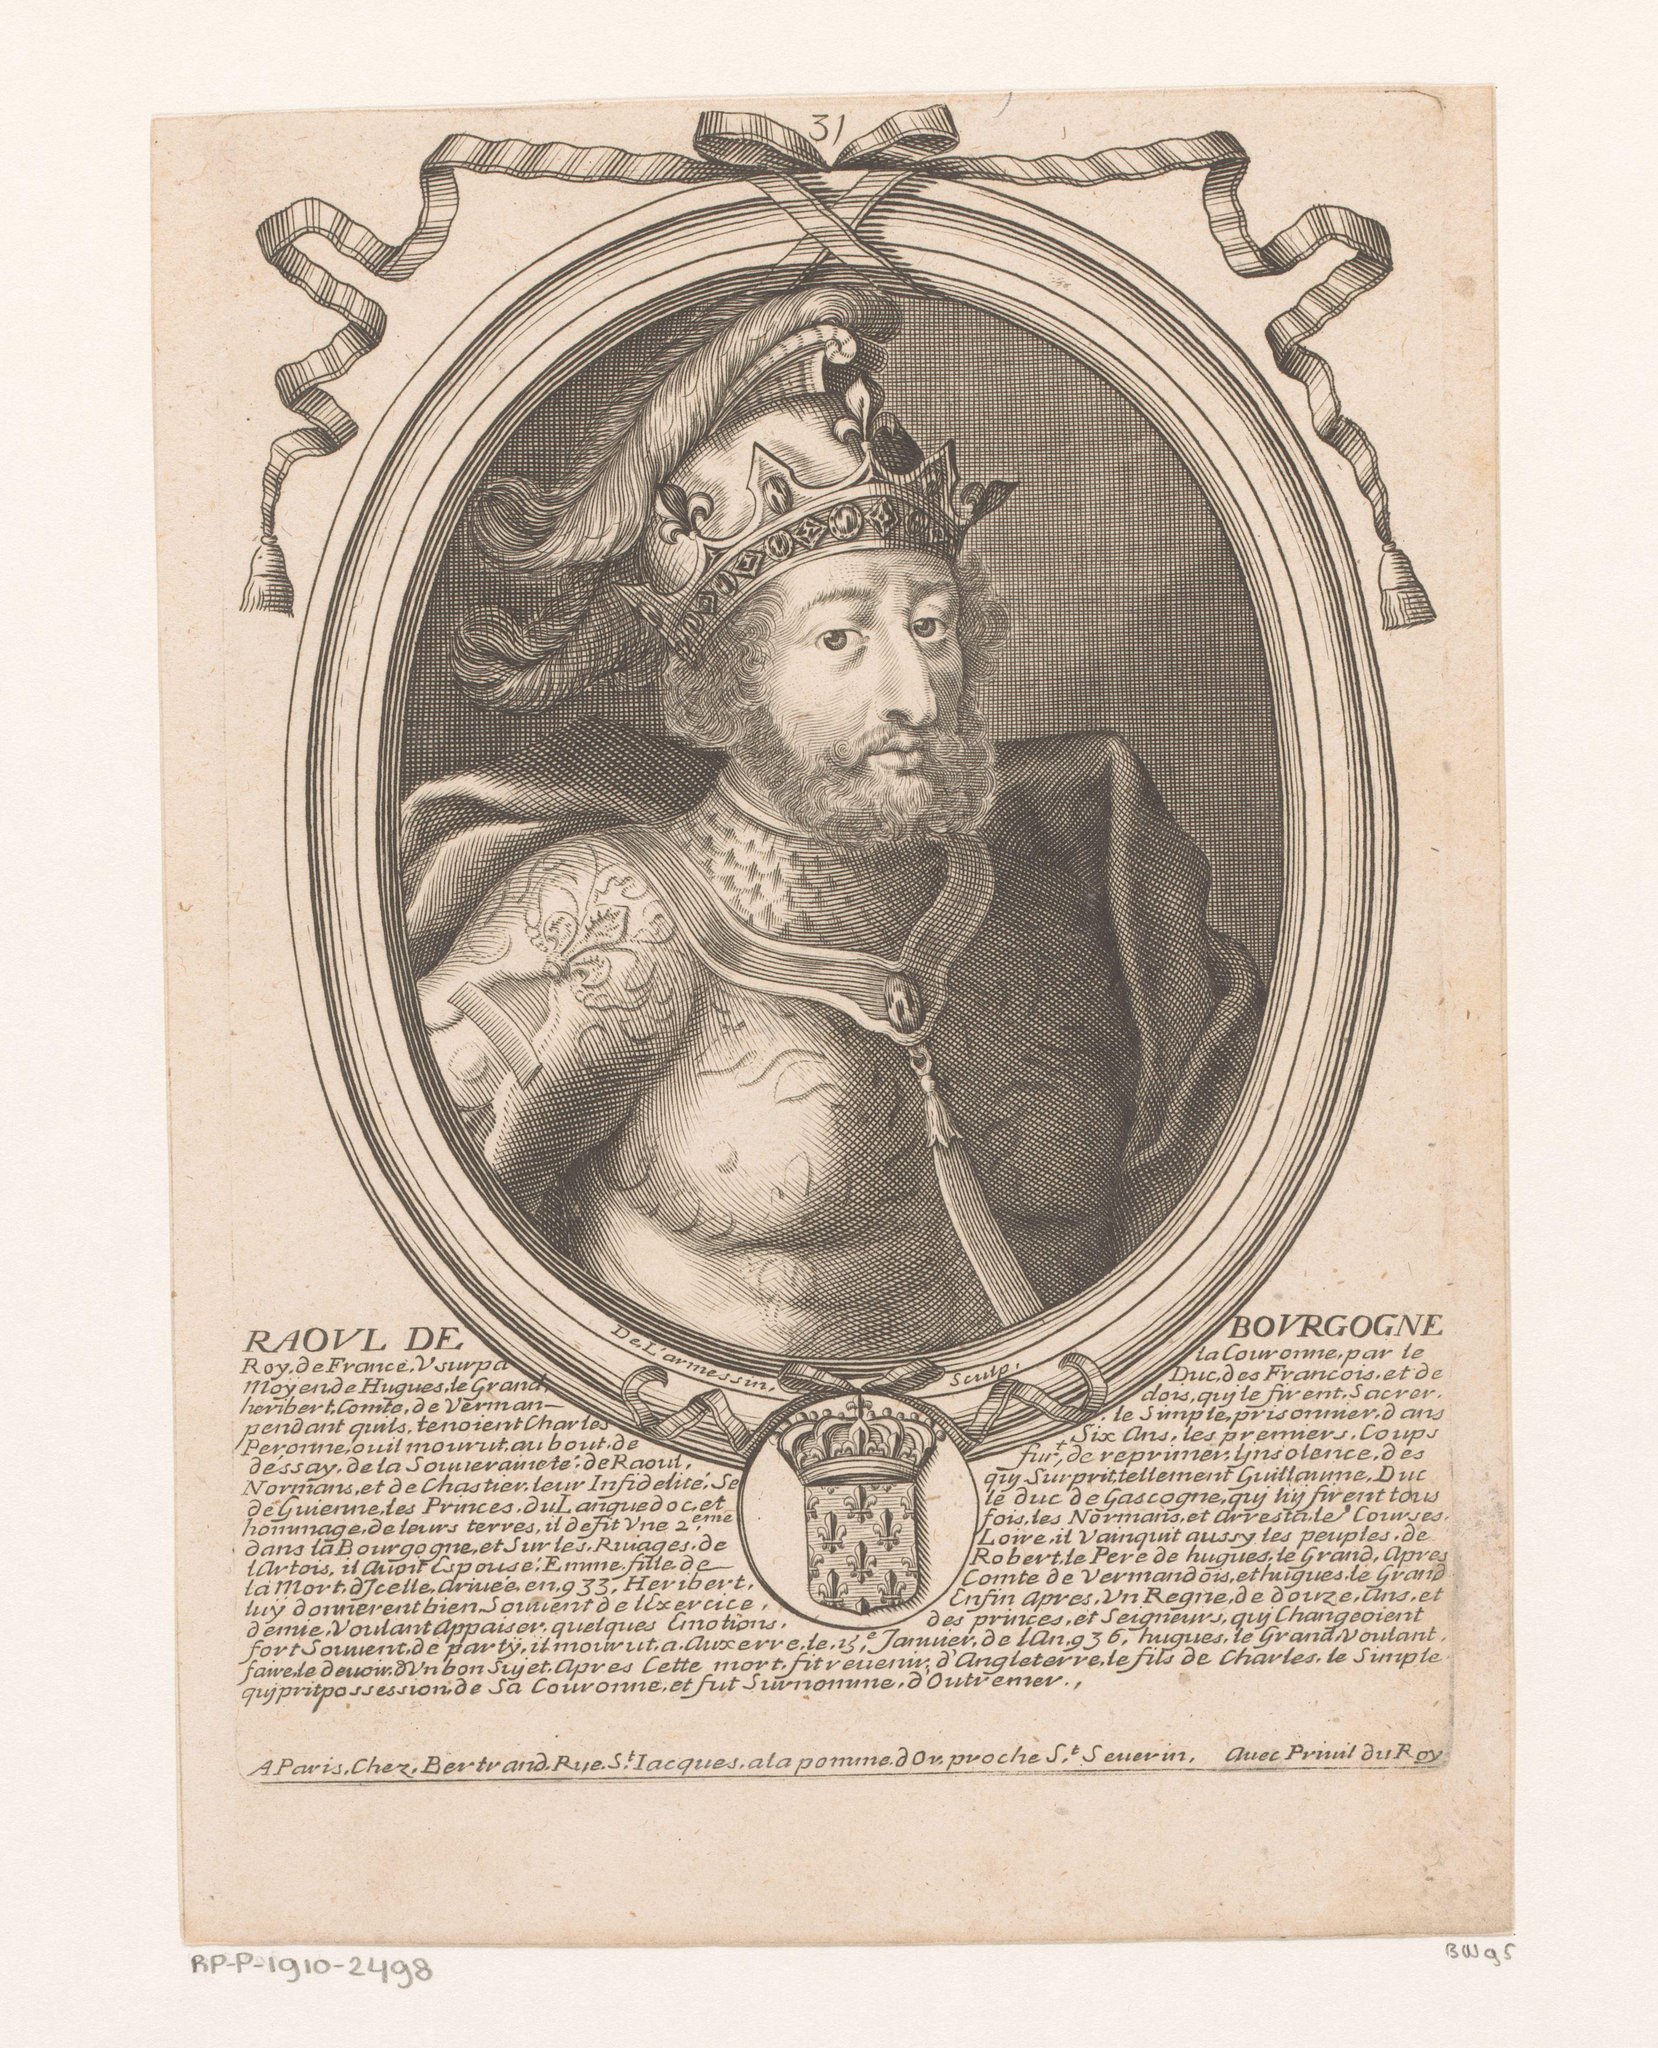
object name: print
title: Portretten van prominente figuren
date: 1647-1678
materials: paper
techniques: engraving, etching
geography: paris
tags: historical persons, king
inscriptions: collector's mark: Lugt 2228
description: Maakt deel uit van een grootschalige serie met portretten van prominente figuren. Binnen de serie bevindt zich een sectie getiteld 'Les Augustes Représentations De tous les Roys De France depuis Pharamond Iusqu'à Louys XIIII'. De serie werd respectievelijk uitgegeven door Pierre Bertrand, door zijn weduwe en door De Larmessin zelf.